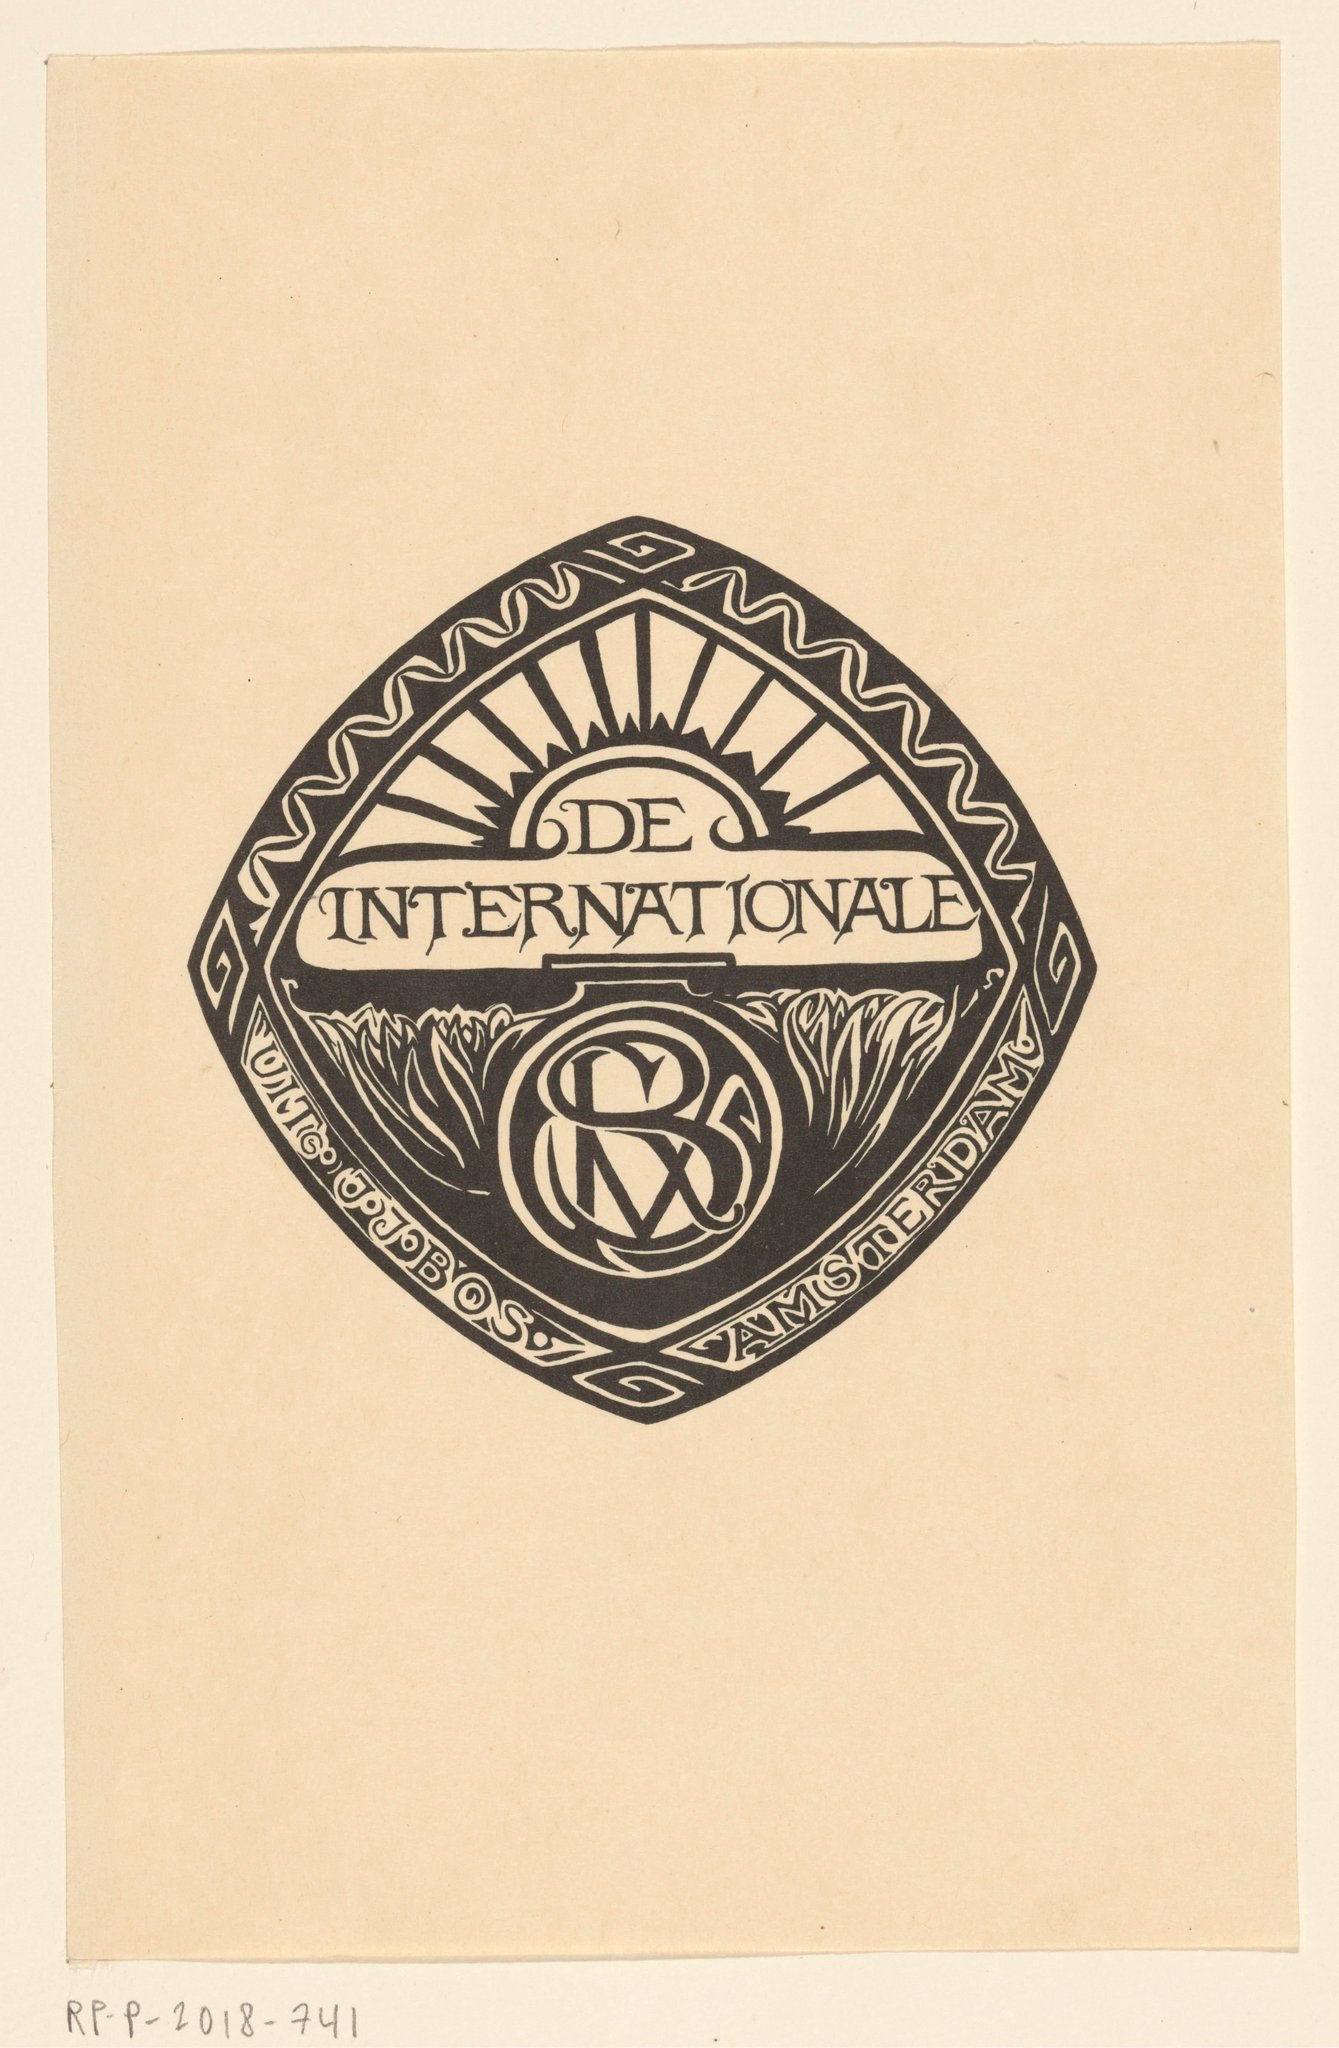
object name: design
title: Zonsopgang of zonsondergang boven een landschap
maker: richard nicolaüs roland holst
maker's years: 1868-1938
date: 1911-1938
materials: paper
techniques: line block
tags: sun as celestial body, letter combinations such as letterword, anagram, letter square, monogram, etc.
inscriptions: number: ‘47’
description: Ontwerp voor: De Internationale, Orgaan van het Revolutionair-Socialistisch Verbond.